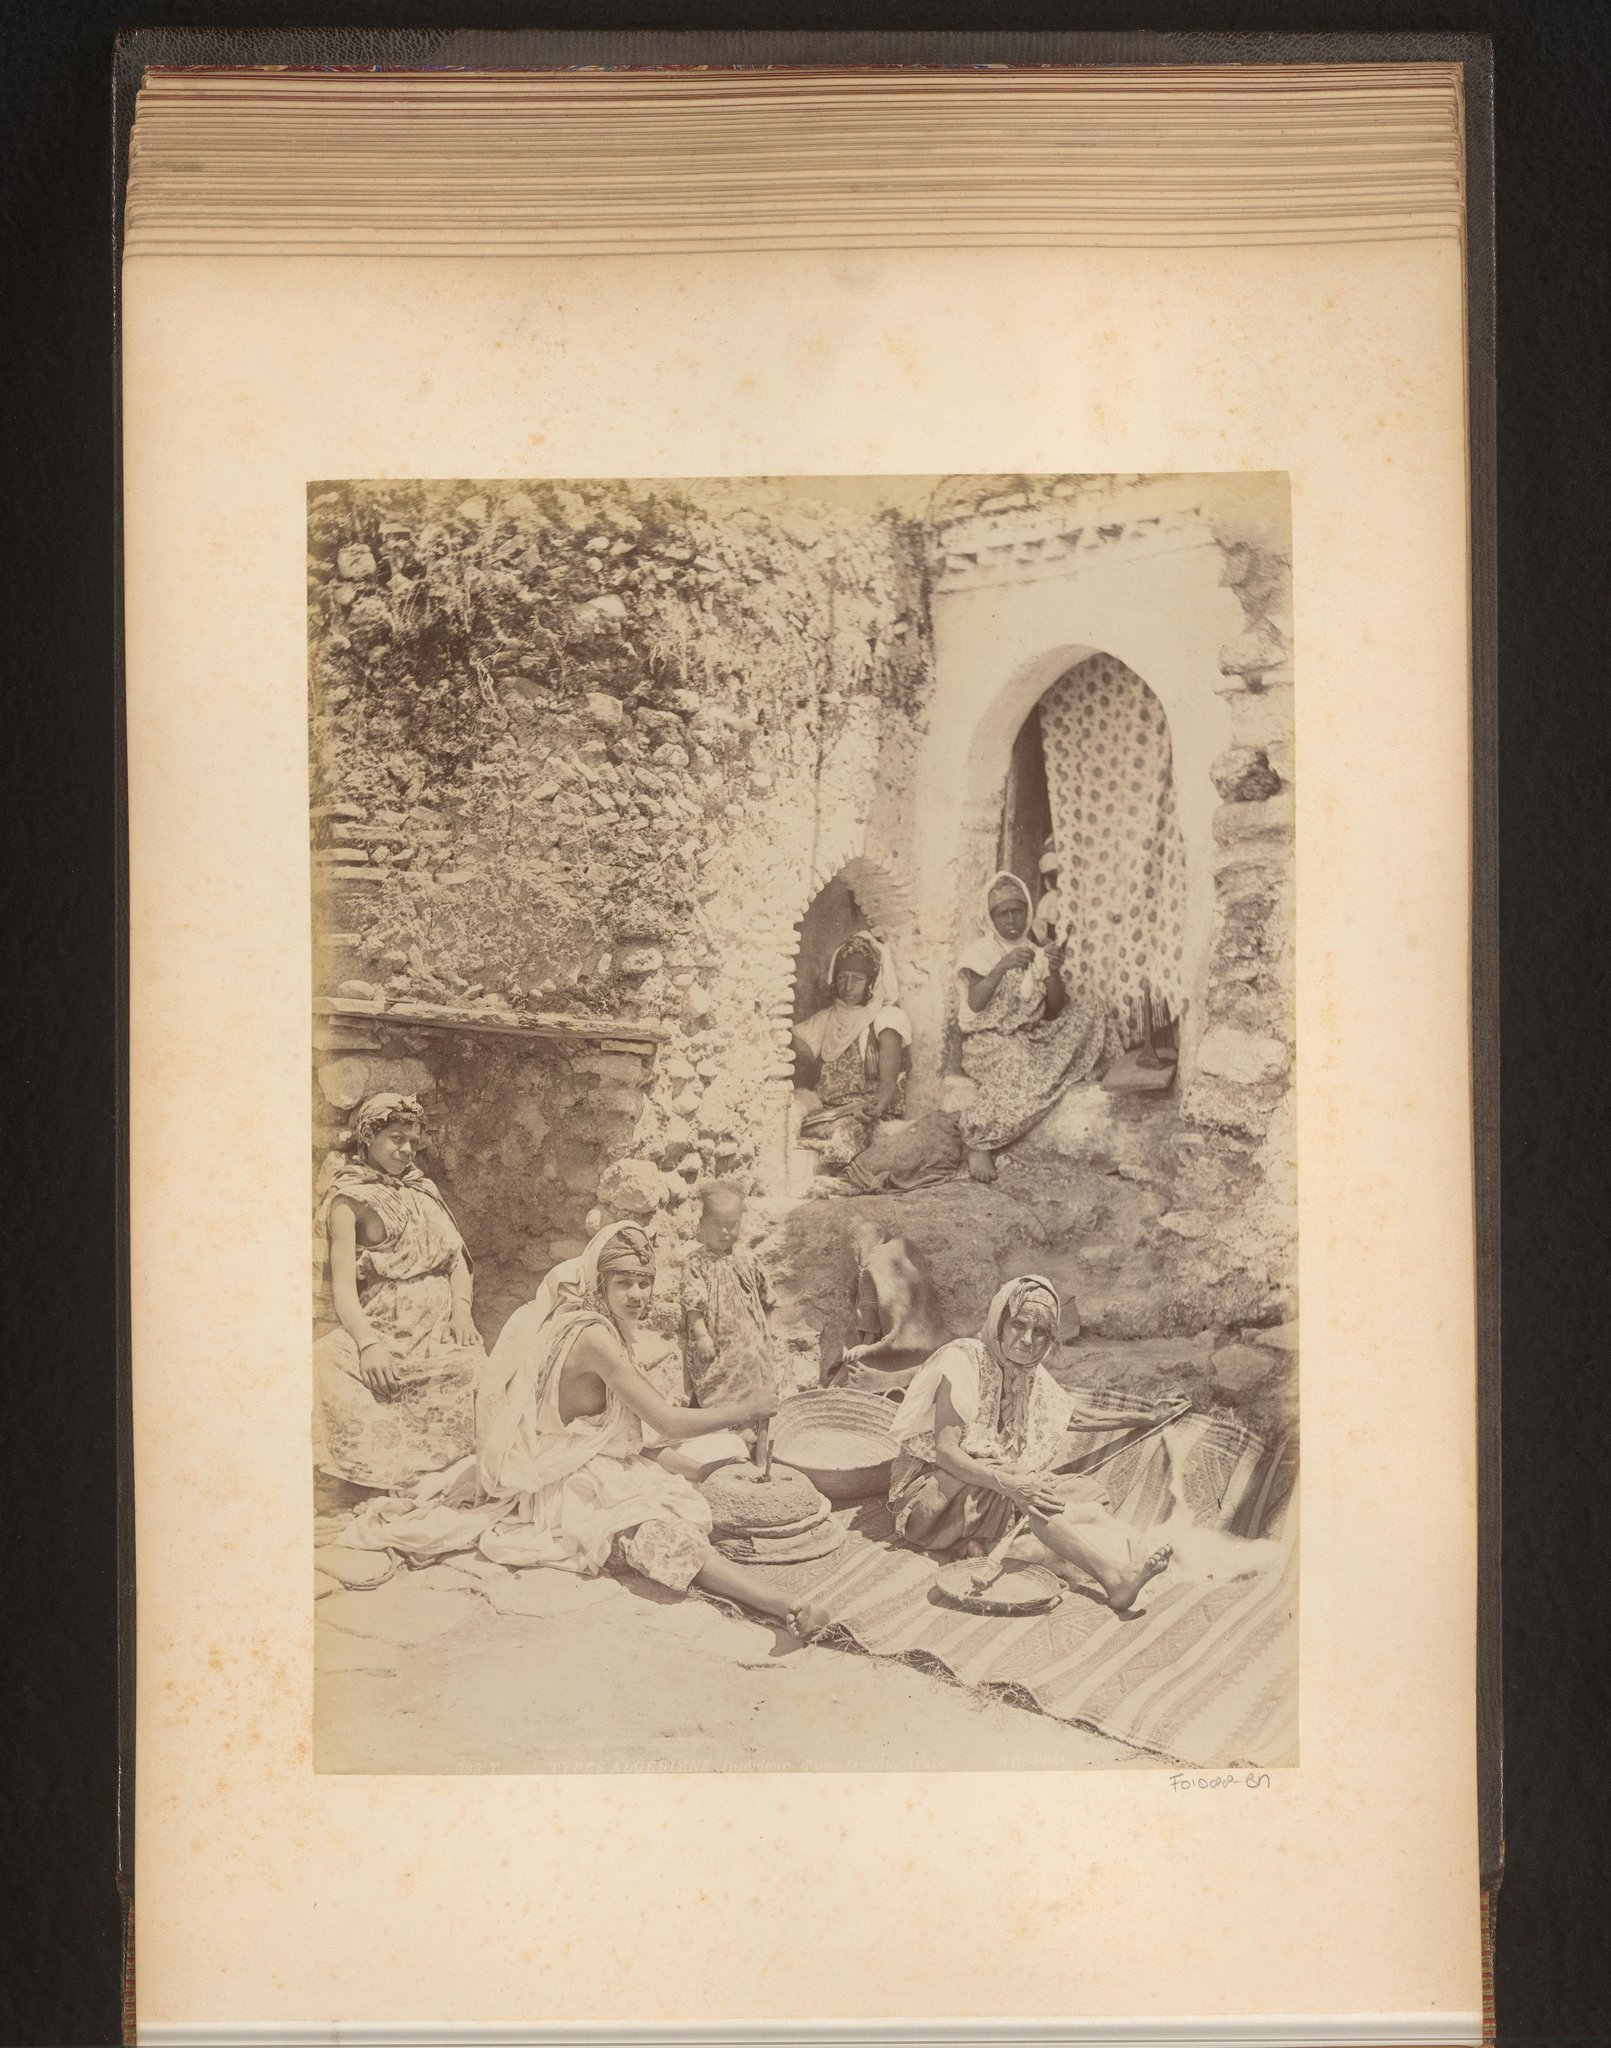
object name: photograph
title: Types Algeriens. Interieur d'une famille Arabe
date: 1880-1900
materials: photographic support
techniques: albumen print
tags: adult woman, spindle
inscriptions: number: ‘333T’, check stamp: ‘J. Kuhn Editeur/ 220 Rue de Rivoli Paris’